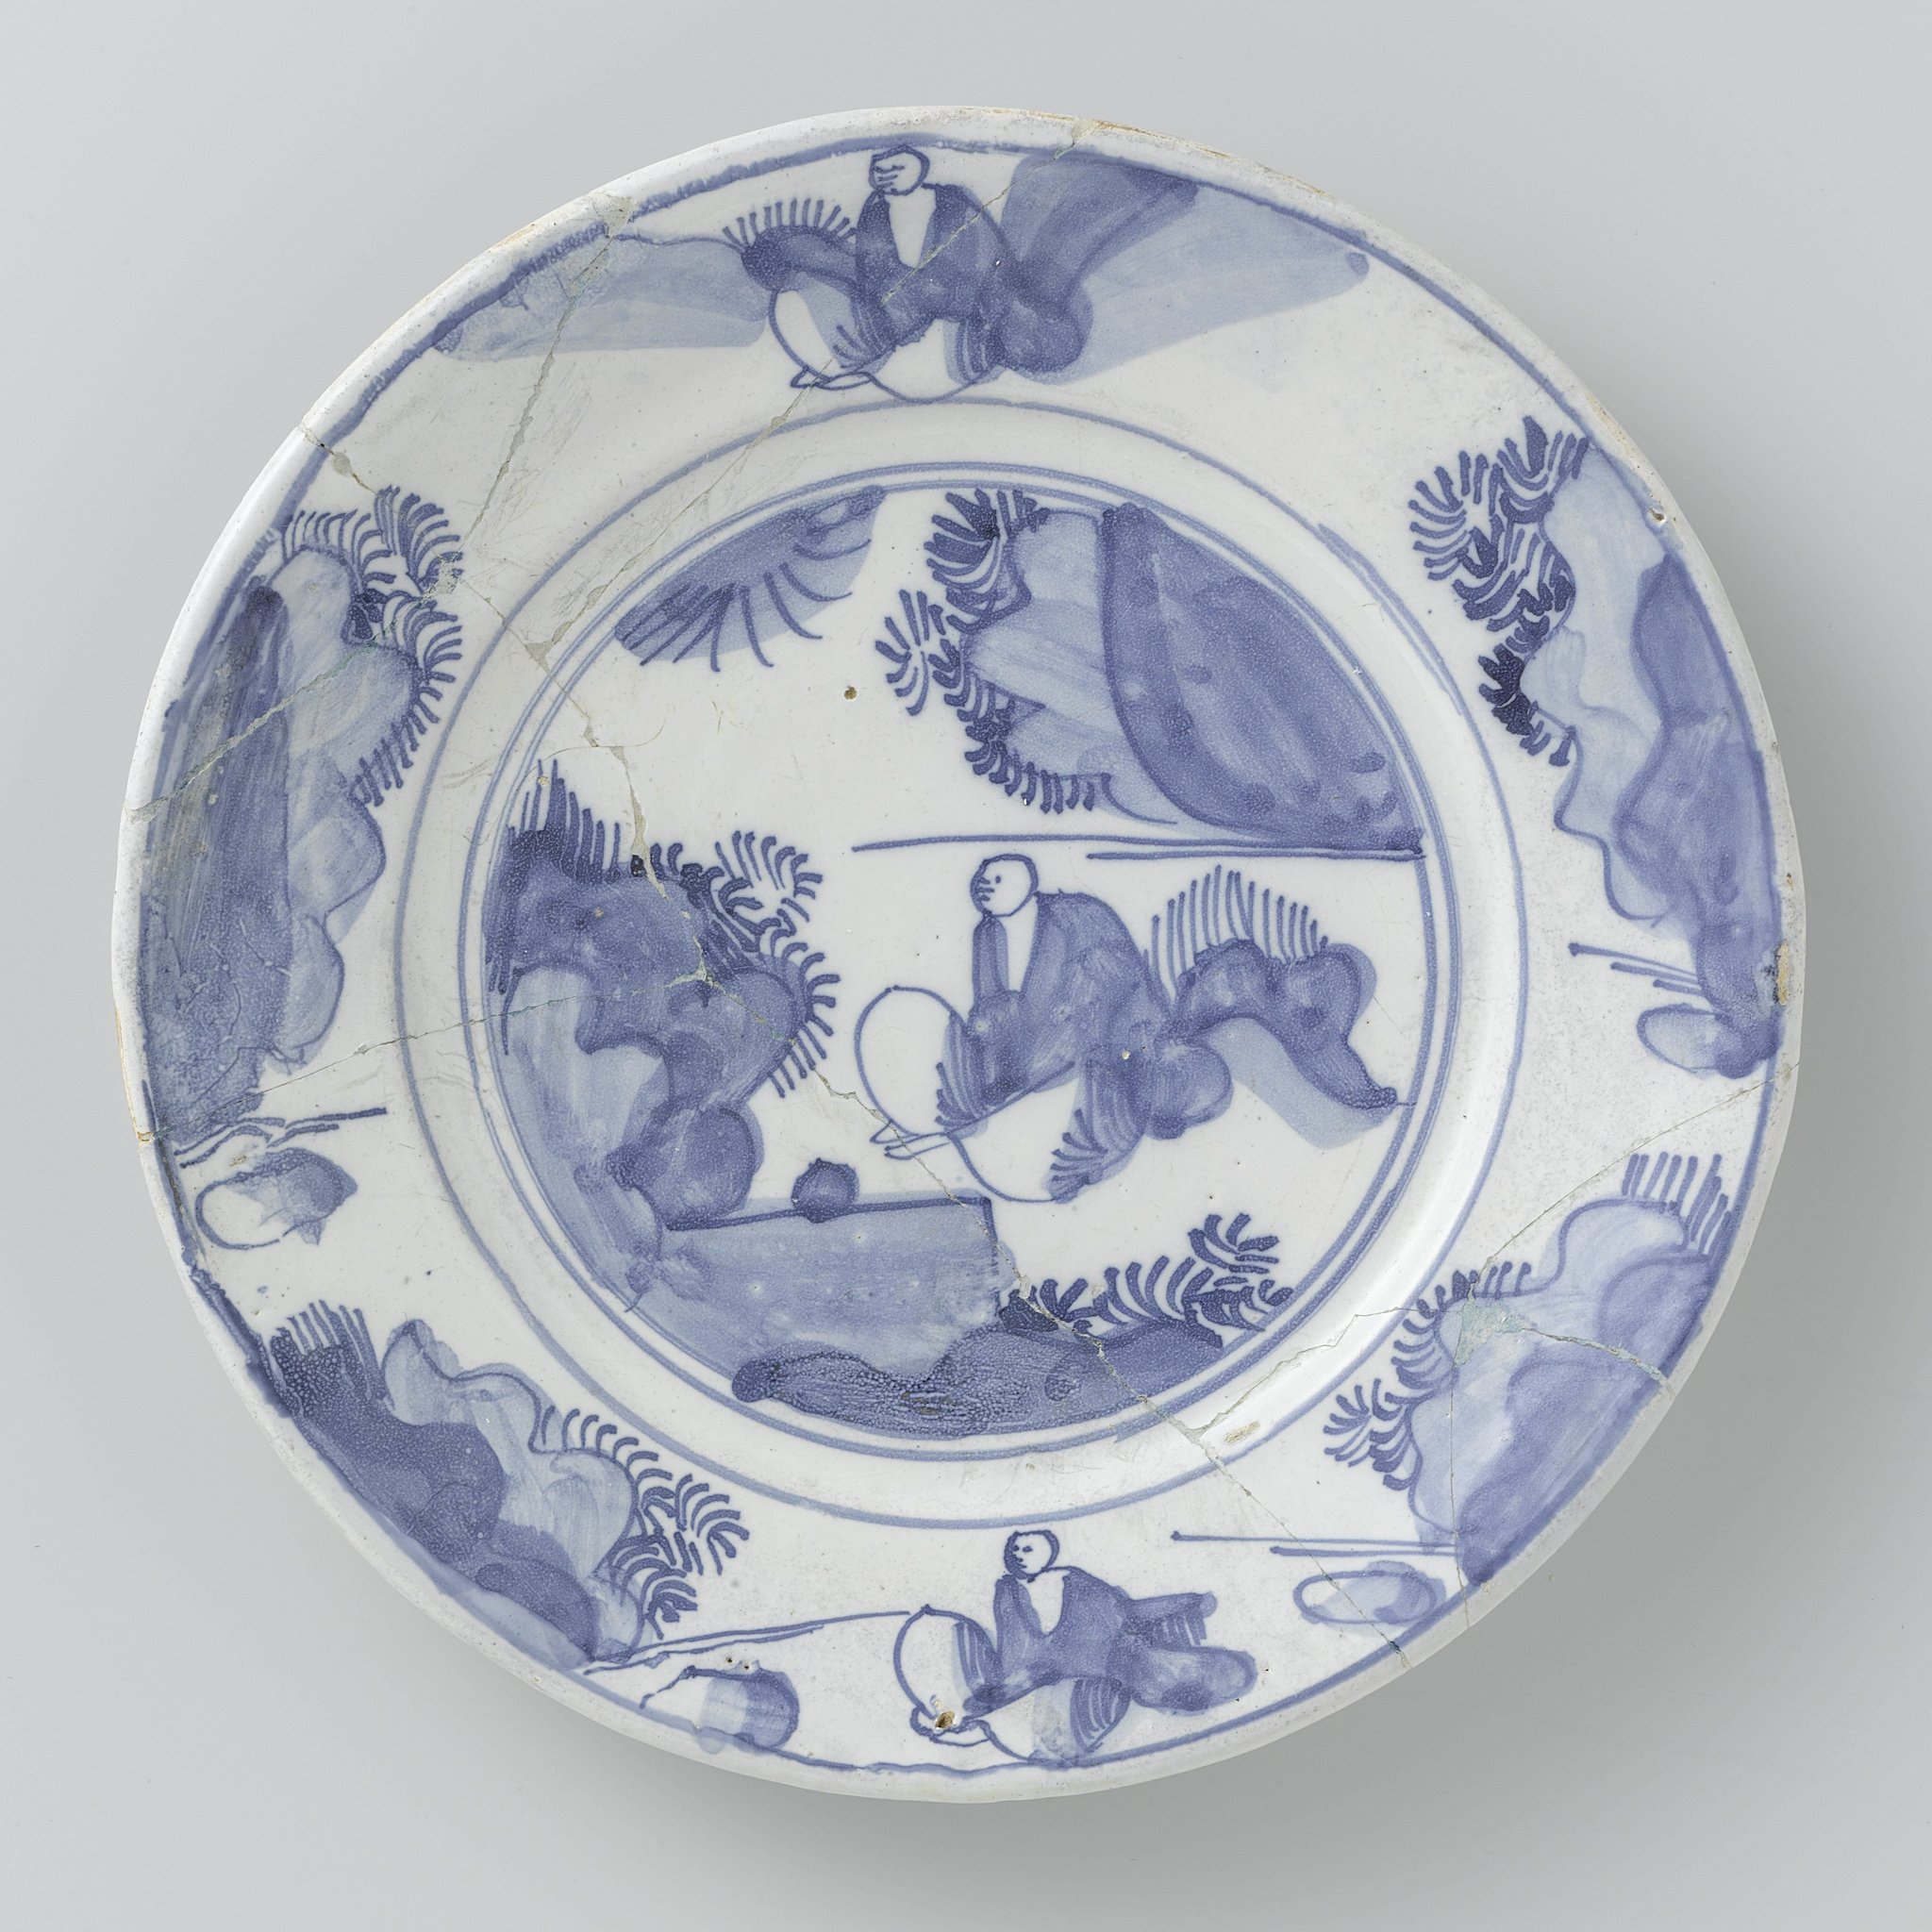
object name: plate dish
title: Bord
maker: Anonymous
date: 1650-1670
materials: earthenware, glaze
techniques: painted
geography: delft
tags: delft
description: Rond bord van blauw beschilderde faience. Op het bord is een landschap met een figuur (Chinees) geschilderd. Het bord is een bodemvondst uit Delft.